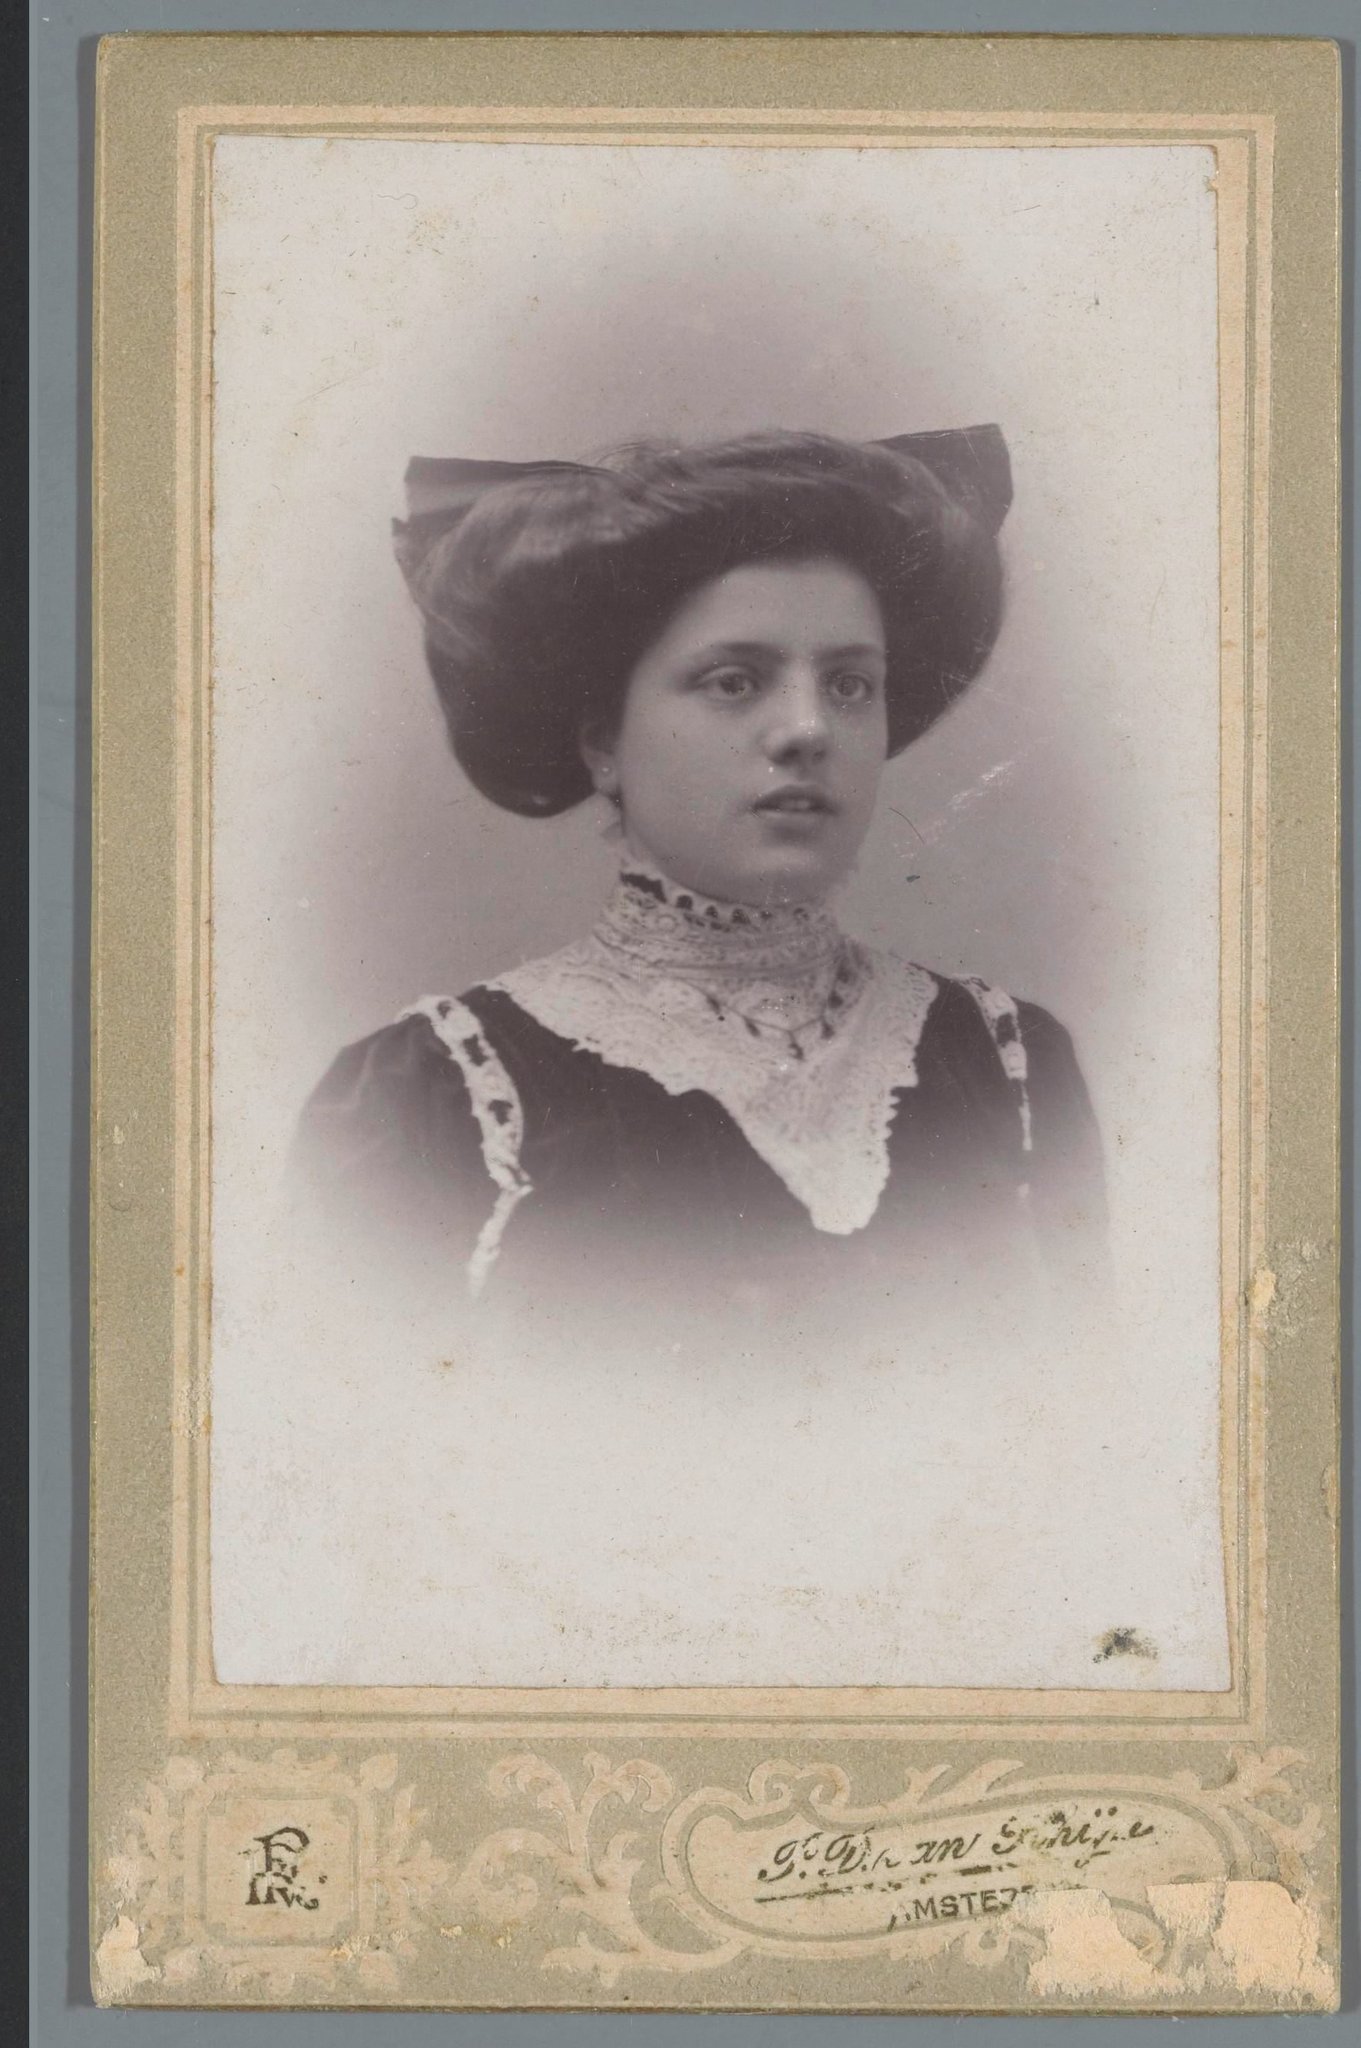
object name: carte de visite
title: Portret van een onbekende vrouw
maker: p.d. van rhijn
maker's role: fotograaf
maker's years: 1874-1942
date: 1896-1918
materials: cardboard, photographic support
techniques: collodion silver print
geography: amsterdam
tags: historical persons - bb - woman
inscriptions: address: ‘PD van Rhijn/ AMSTERDAM’